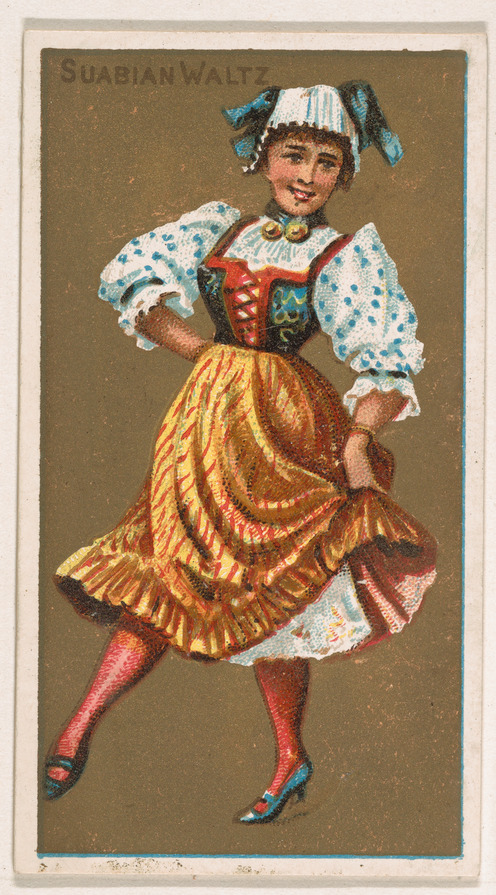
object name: print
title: Suabian Waltz, from National Dances (N225, Type 1) issued by Kinney Bros.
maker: kinney brothers tobacco company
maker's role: publisher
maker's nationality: american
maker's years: 1869-2011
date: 1889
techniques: color lithograph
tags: women,dancing